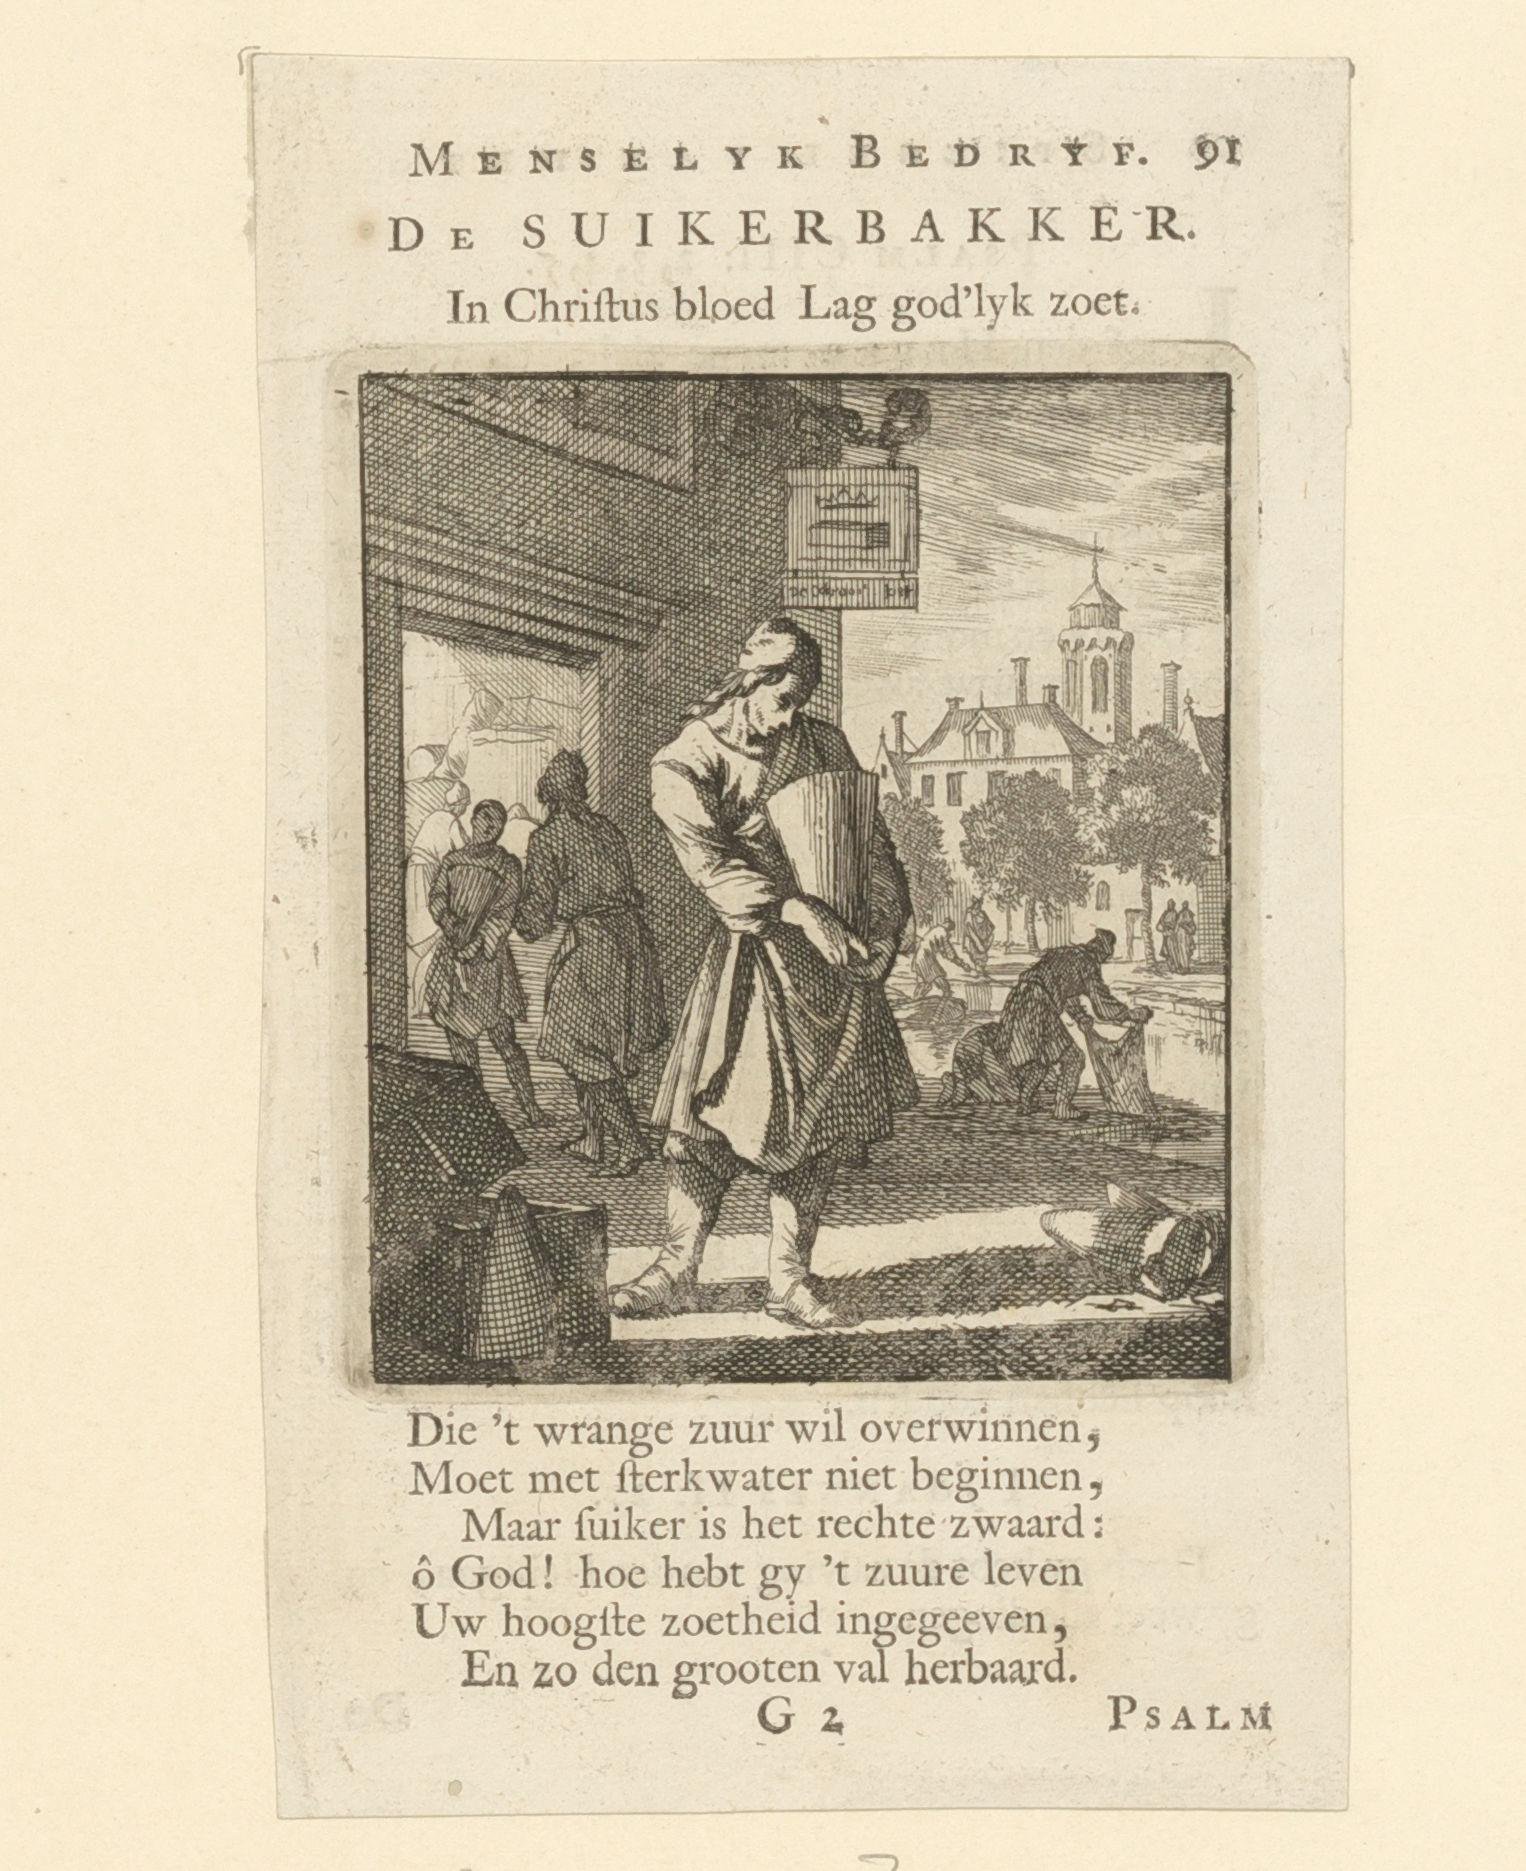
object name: book illustration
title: Suikerbakker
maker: cornelis van der sys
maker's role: publisher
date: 1718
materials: paper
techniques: etching, letterpress printing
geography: amsterdam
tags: handicrafts, craftsman at work, loaf-sugar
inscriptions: stamp, stamp, collector's mark: Lugt 1641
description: Prent oorspronkelijk verschenen in de 100-delige serie beroepsprenten van Jan en Caspar Luyken, getiteld: Het menselyk bedryf. S.l.s.n., 1694 (eerste druk). Daarna is de titel en het vers afgesneden. De prenten in diverse publicaties verschenen en gekopieerd. Huidige staat uit: Luyken, Jan en Caspar. Spiegel van het menselyk bedryf (...). Amsterdam: Cornelis van der Sys, 1718. Prent waarschijnlijk ook gebruikt in eerdere (1704) en latere (1730, 1749, 1767) publicaties.